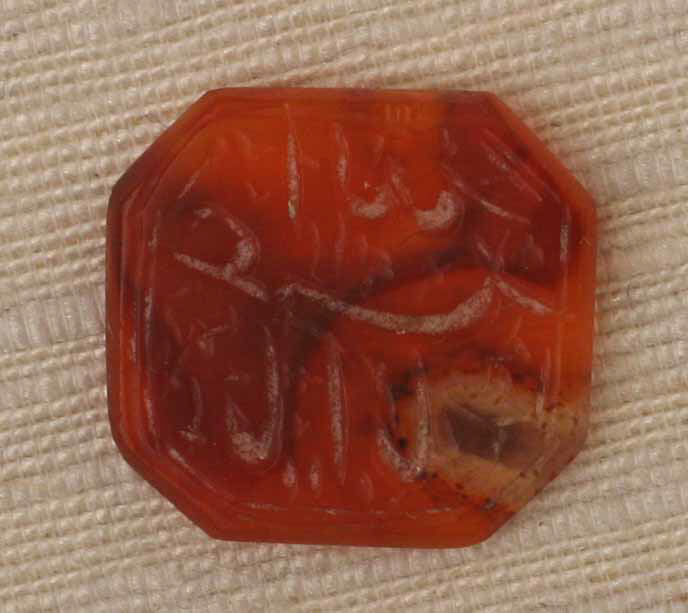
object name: stamp seal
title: Seal Stamp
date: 1698-1708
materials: stone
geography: iran